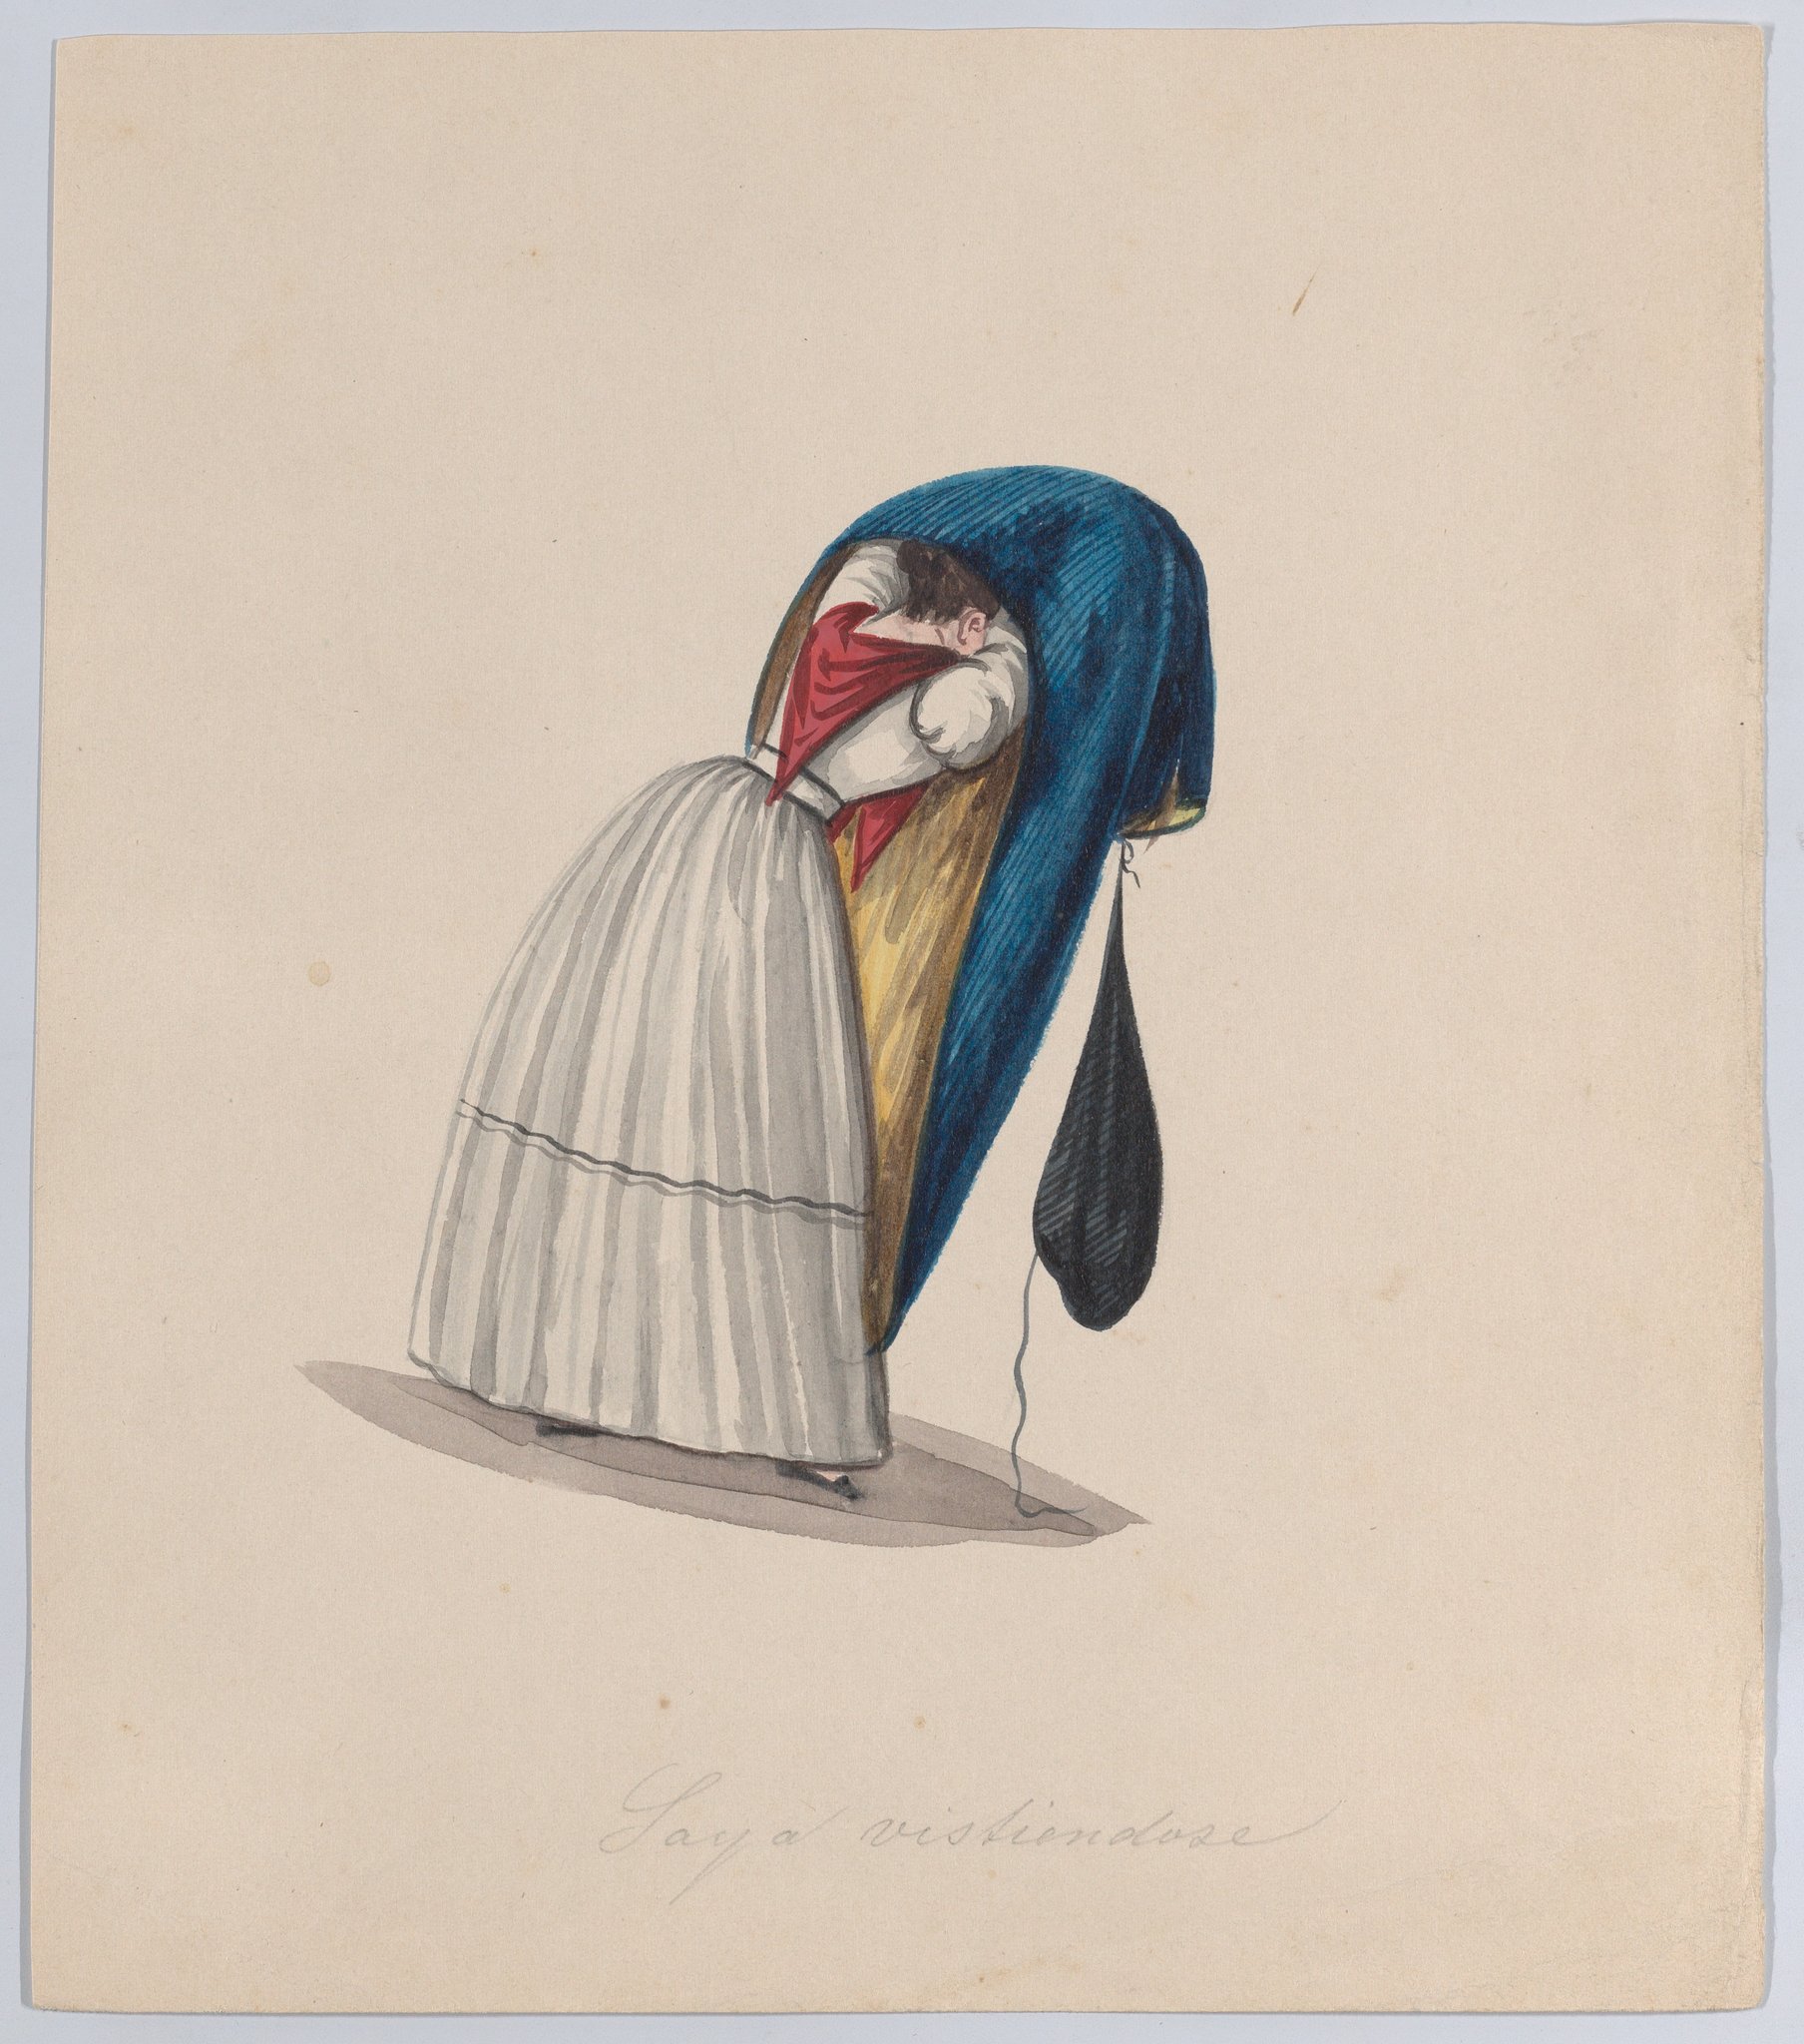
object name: drawing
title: A woman getting into her saya viewed from behind, from a group of drawings depicting Peruvian dress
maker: francisco (pancho) fierro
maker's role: artist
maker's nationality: african peruvian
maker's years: 1807-1879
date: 1848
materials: watercolor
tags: men,women